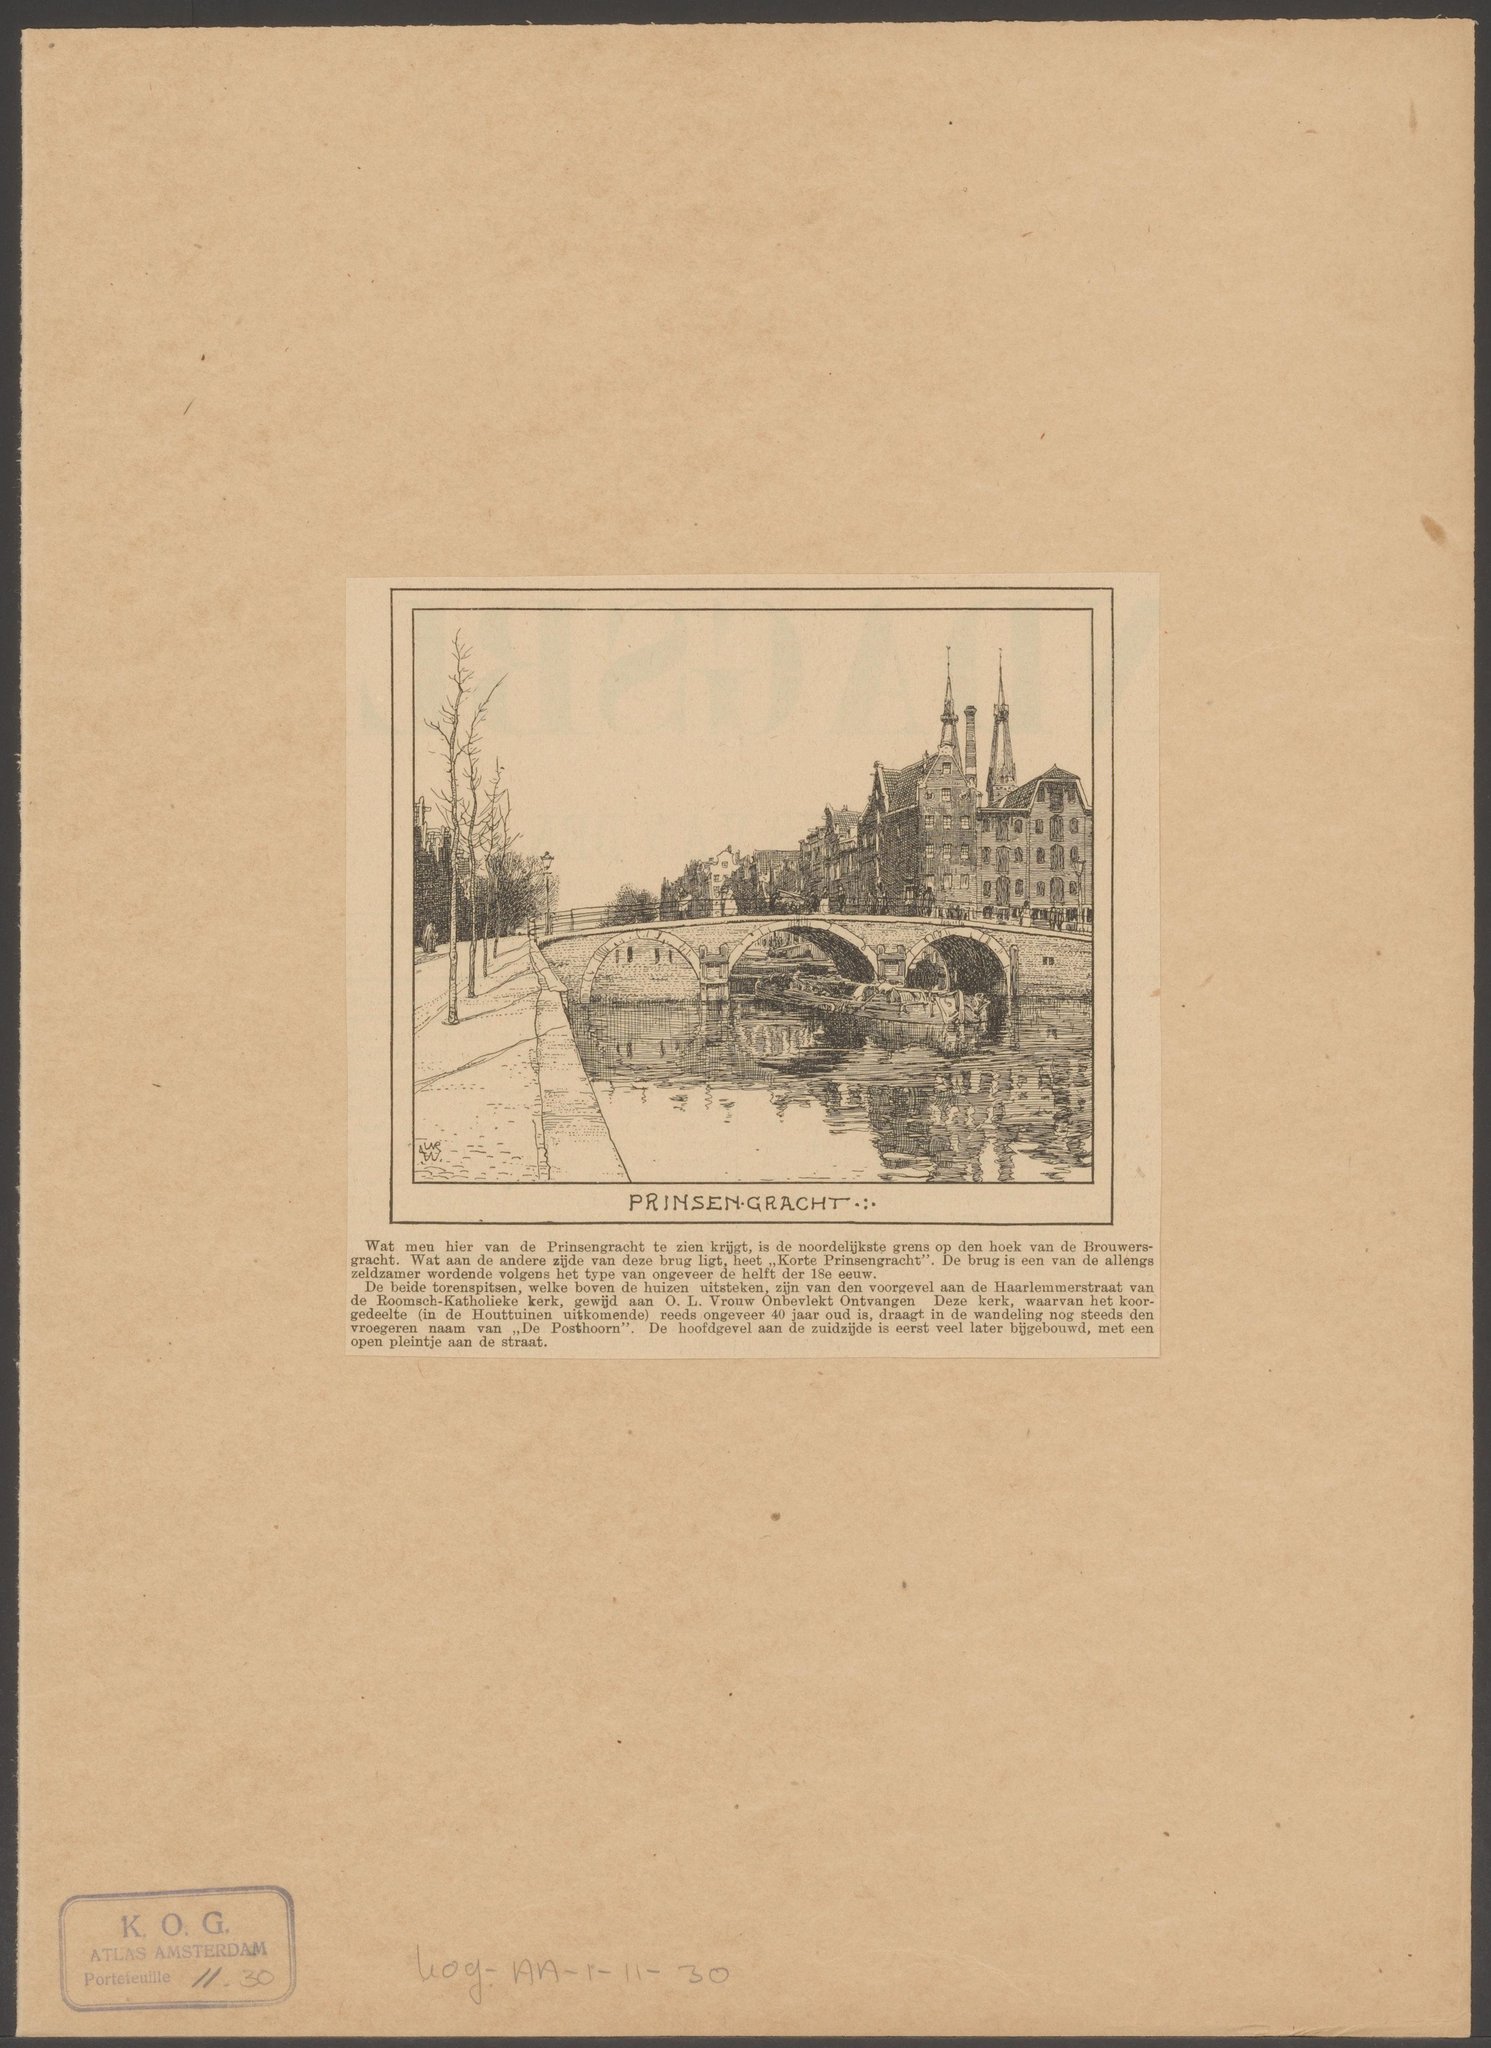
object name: photomechanical print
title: Gezicht op de Prinsengracht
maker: willem wenckebach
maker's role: designer, draughtsman, painter, print maker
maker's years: 1860-1937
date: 1870-1923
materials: paper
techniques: letterpress printing, line block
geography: amsterdam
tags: city-view in general; 'veduta', canal, bridge in city across river, canal, etc.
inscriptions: collector's mark: ‘11.30’ Lugt 1641b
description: Onderwerpsrubriek binnen de Atlas Amsterdam: Prinsengracht, Korte Prinsengracht, Prins Hendrikkade. Zie ook Portefeuille 1: gezichten van het IJ op de stad.